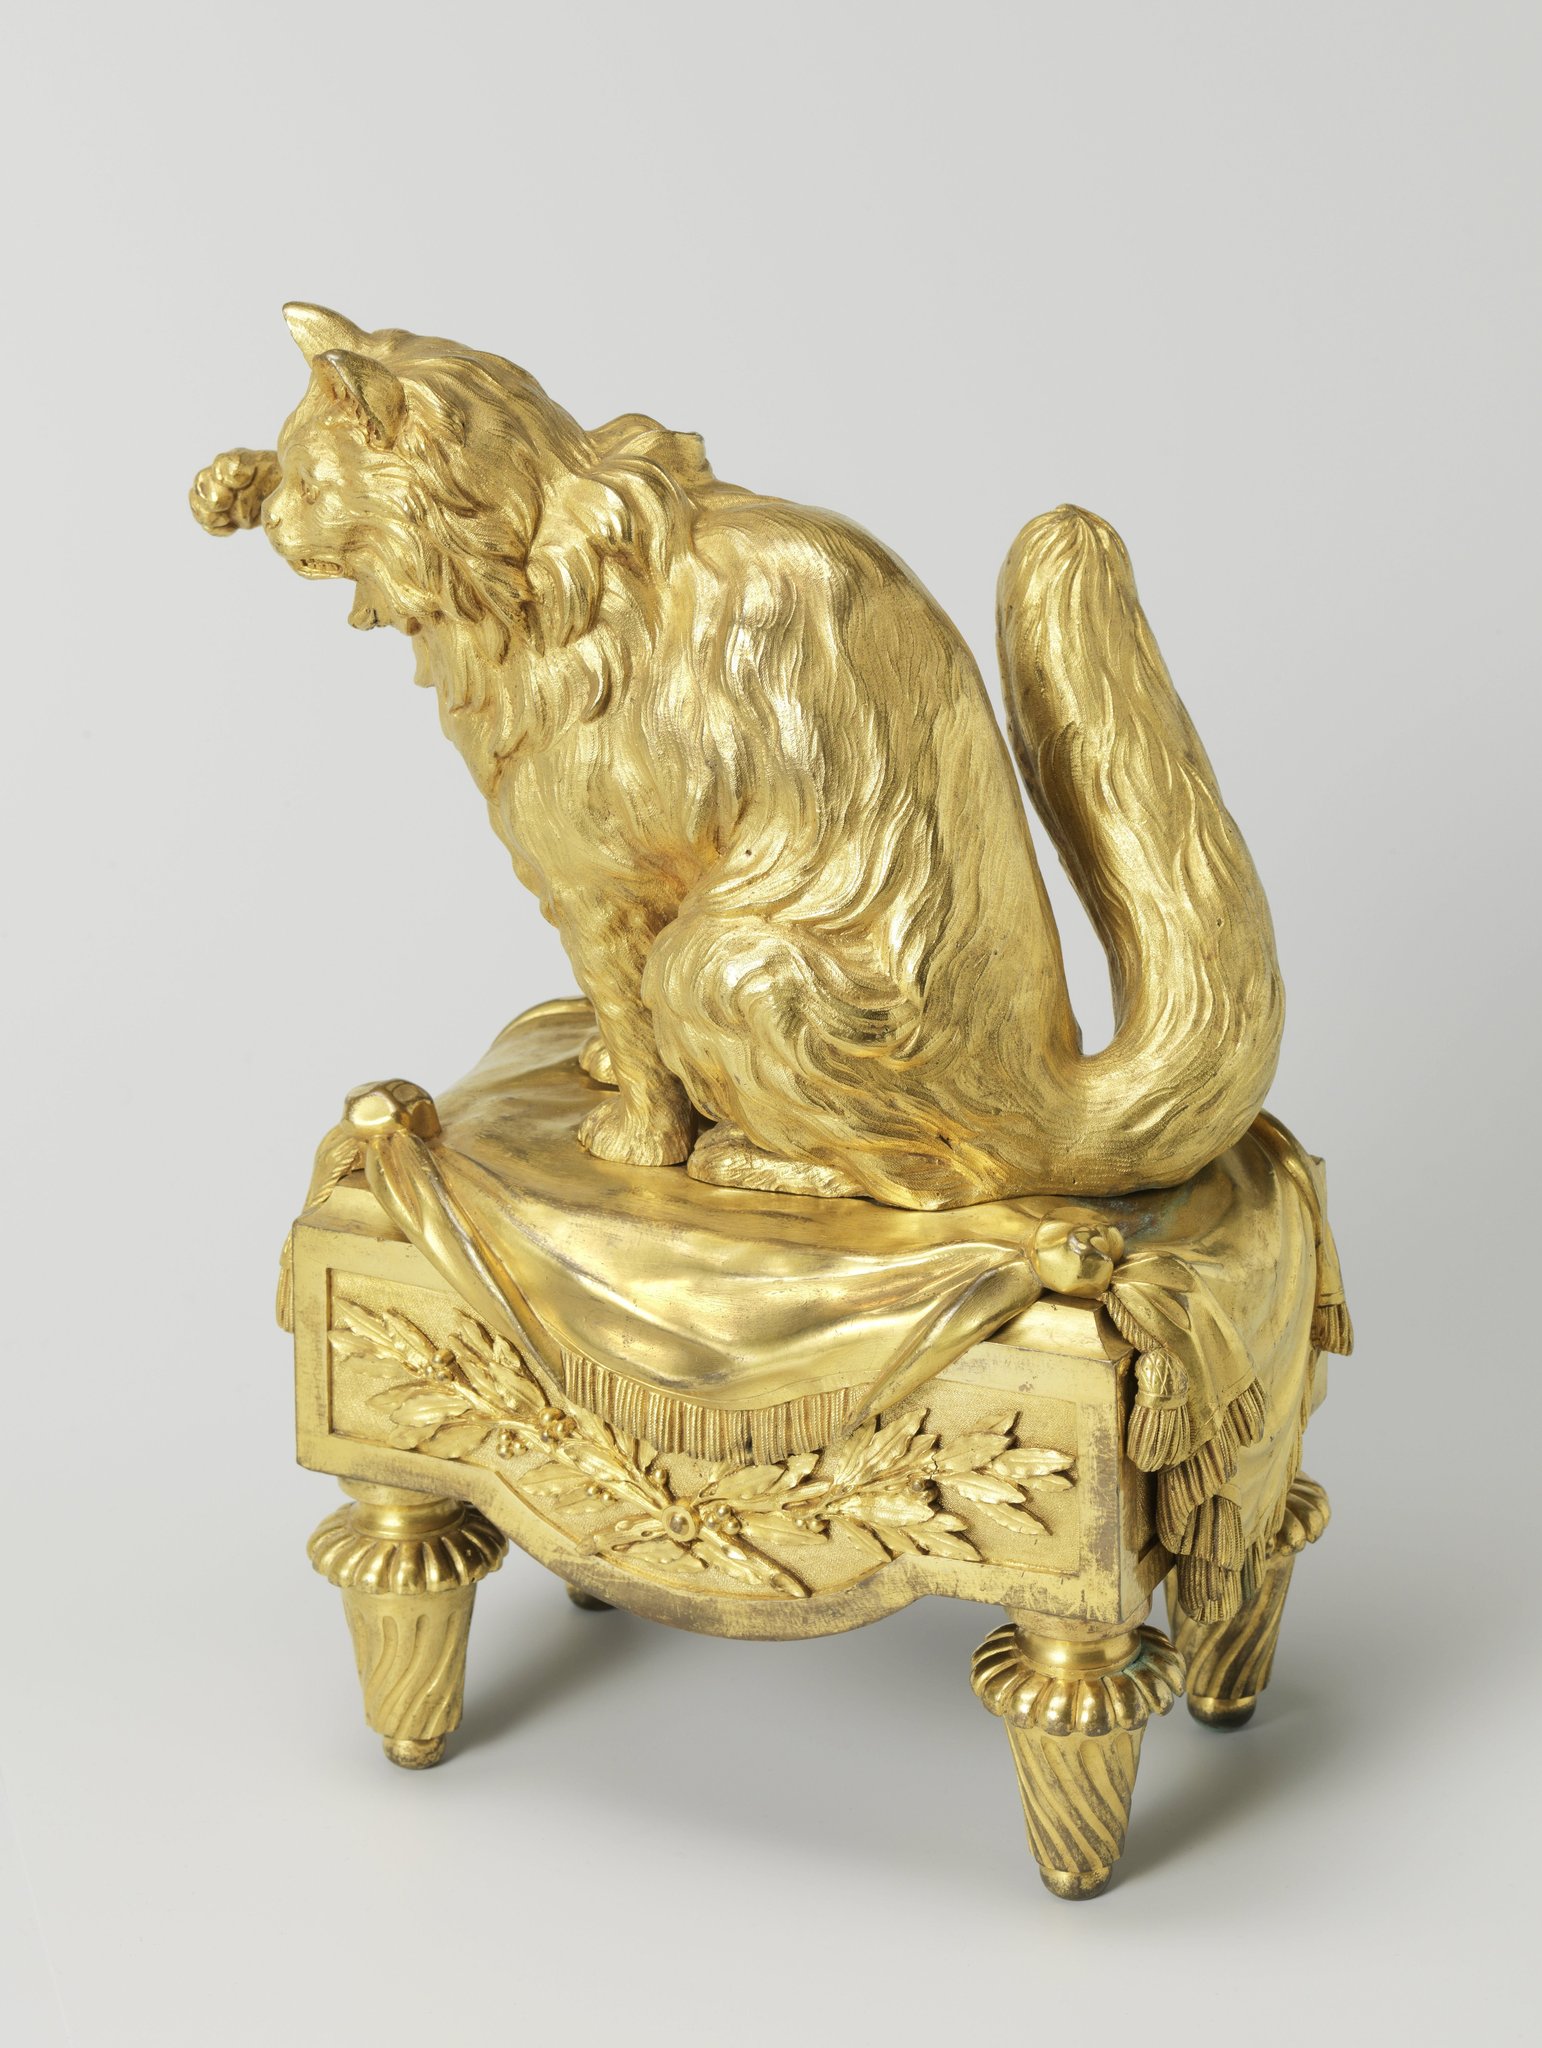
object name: andiron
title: Pair of firedogs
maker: philippe caffieri (le jeune)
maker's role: print maker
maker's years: 1714-1774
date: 1770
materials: bronze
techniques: gilding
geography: paris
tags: cat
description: Firedogs were placed in the hearth as supports for the metal rods on which the logs of wood were laid. The poodle and the cat seem to be warming them-selves by the fire. The famous bronze-caster Philippe Caffieri is known to have made firedogs with such animals.